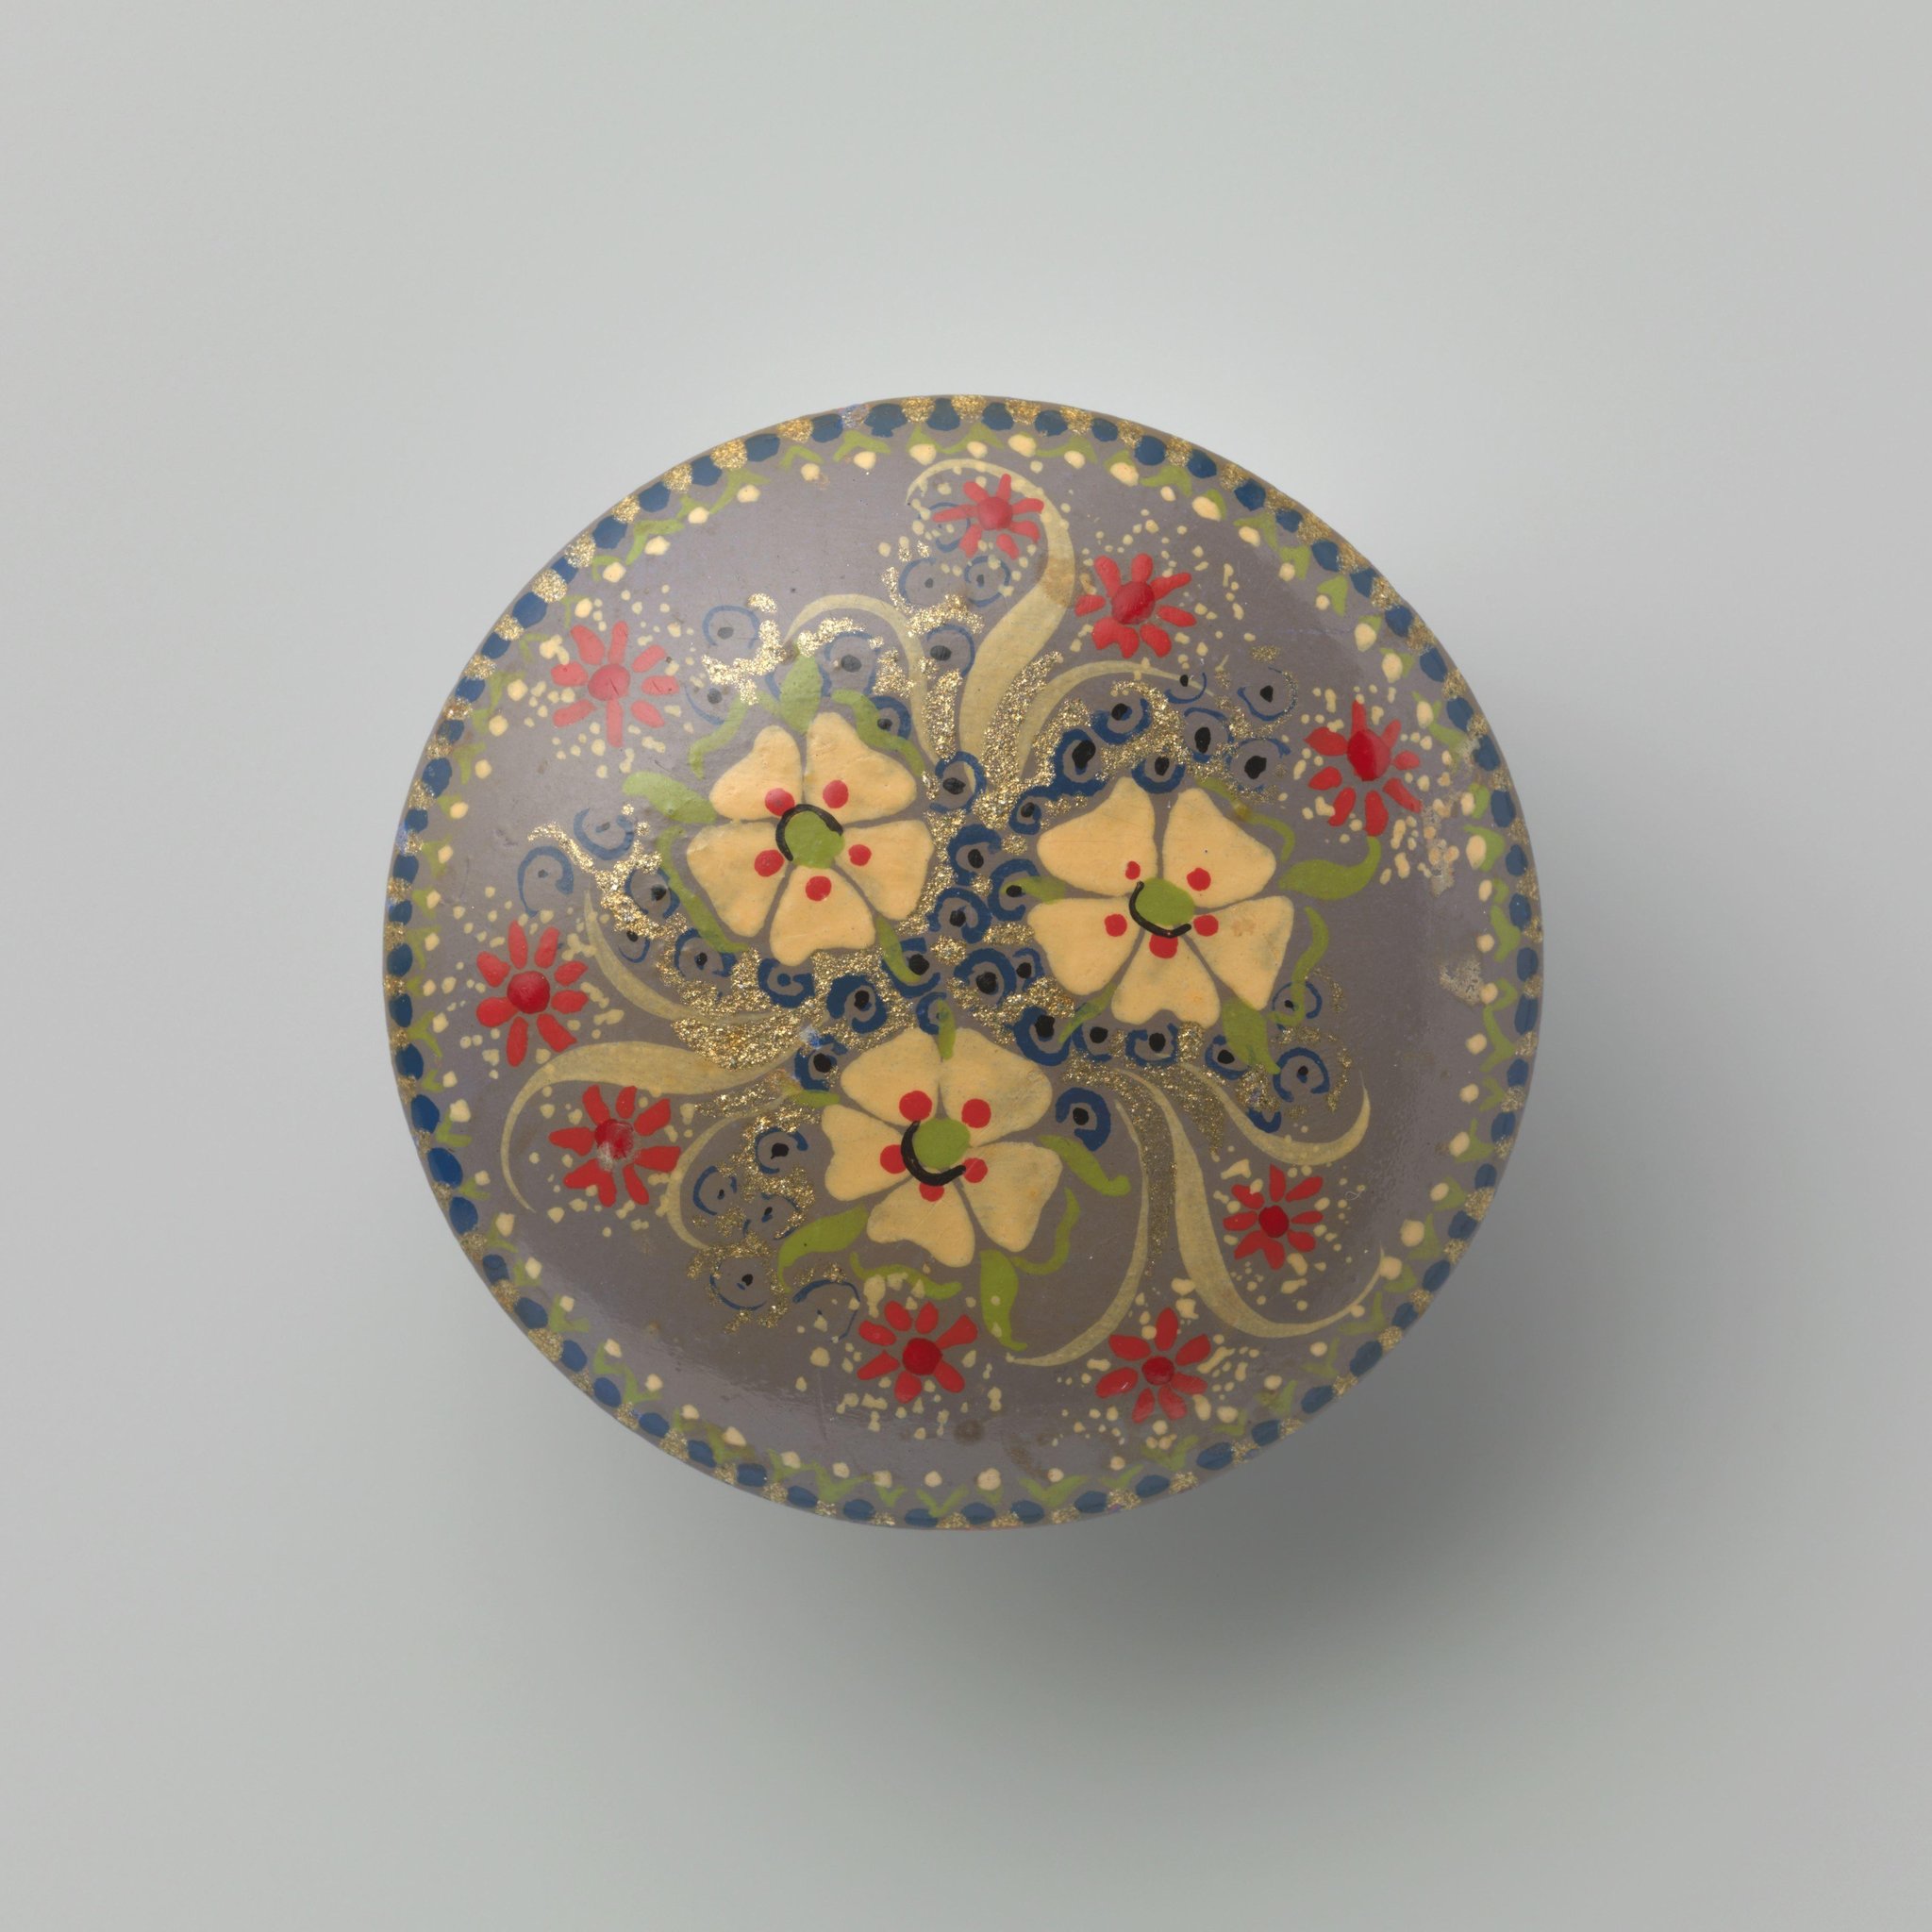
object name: brooch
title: Ronde broche van hout met bloemdecoratie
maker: Anonymous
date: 1945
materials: metal, wood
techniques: painted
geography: netherlands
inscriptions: : ‘Dicky D. 4-10-'45’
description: Ronde convexe broche van hout met veelkleurig geschilderde bloemdecoratie op grijze grond, voorzien van een haaksluiting.